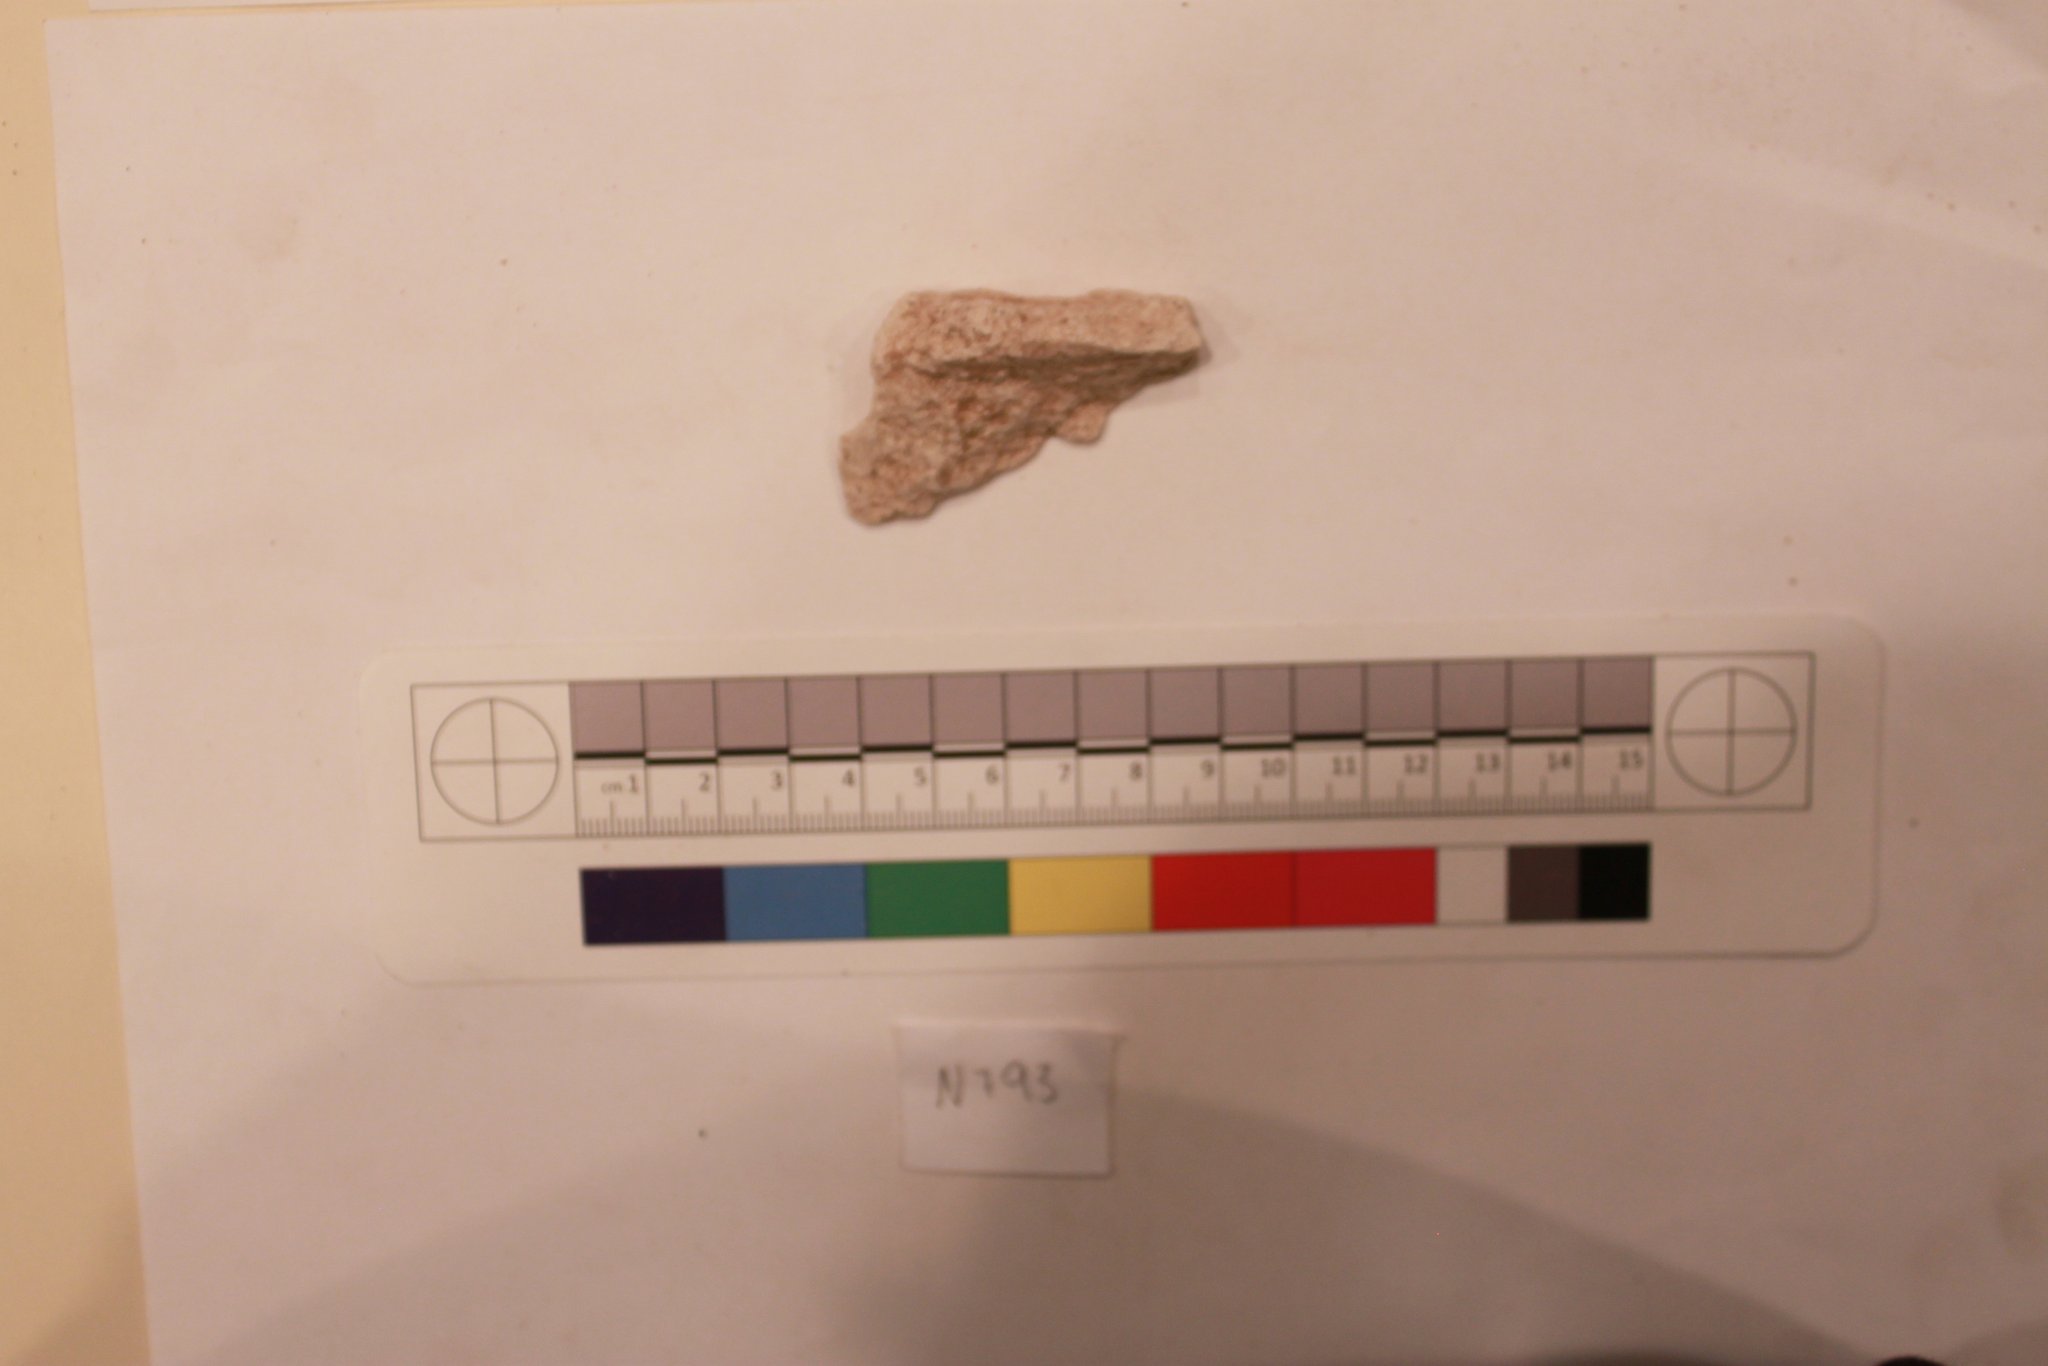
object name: fragment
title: Stucco Fragment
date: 701-1200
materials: plaster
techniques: carving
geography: iran